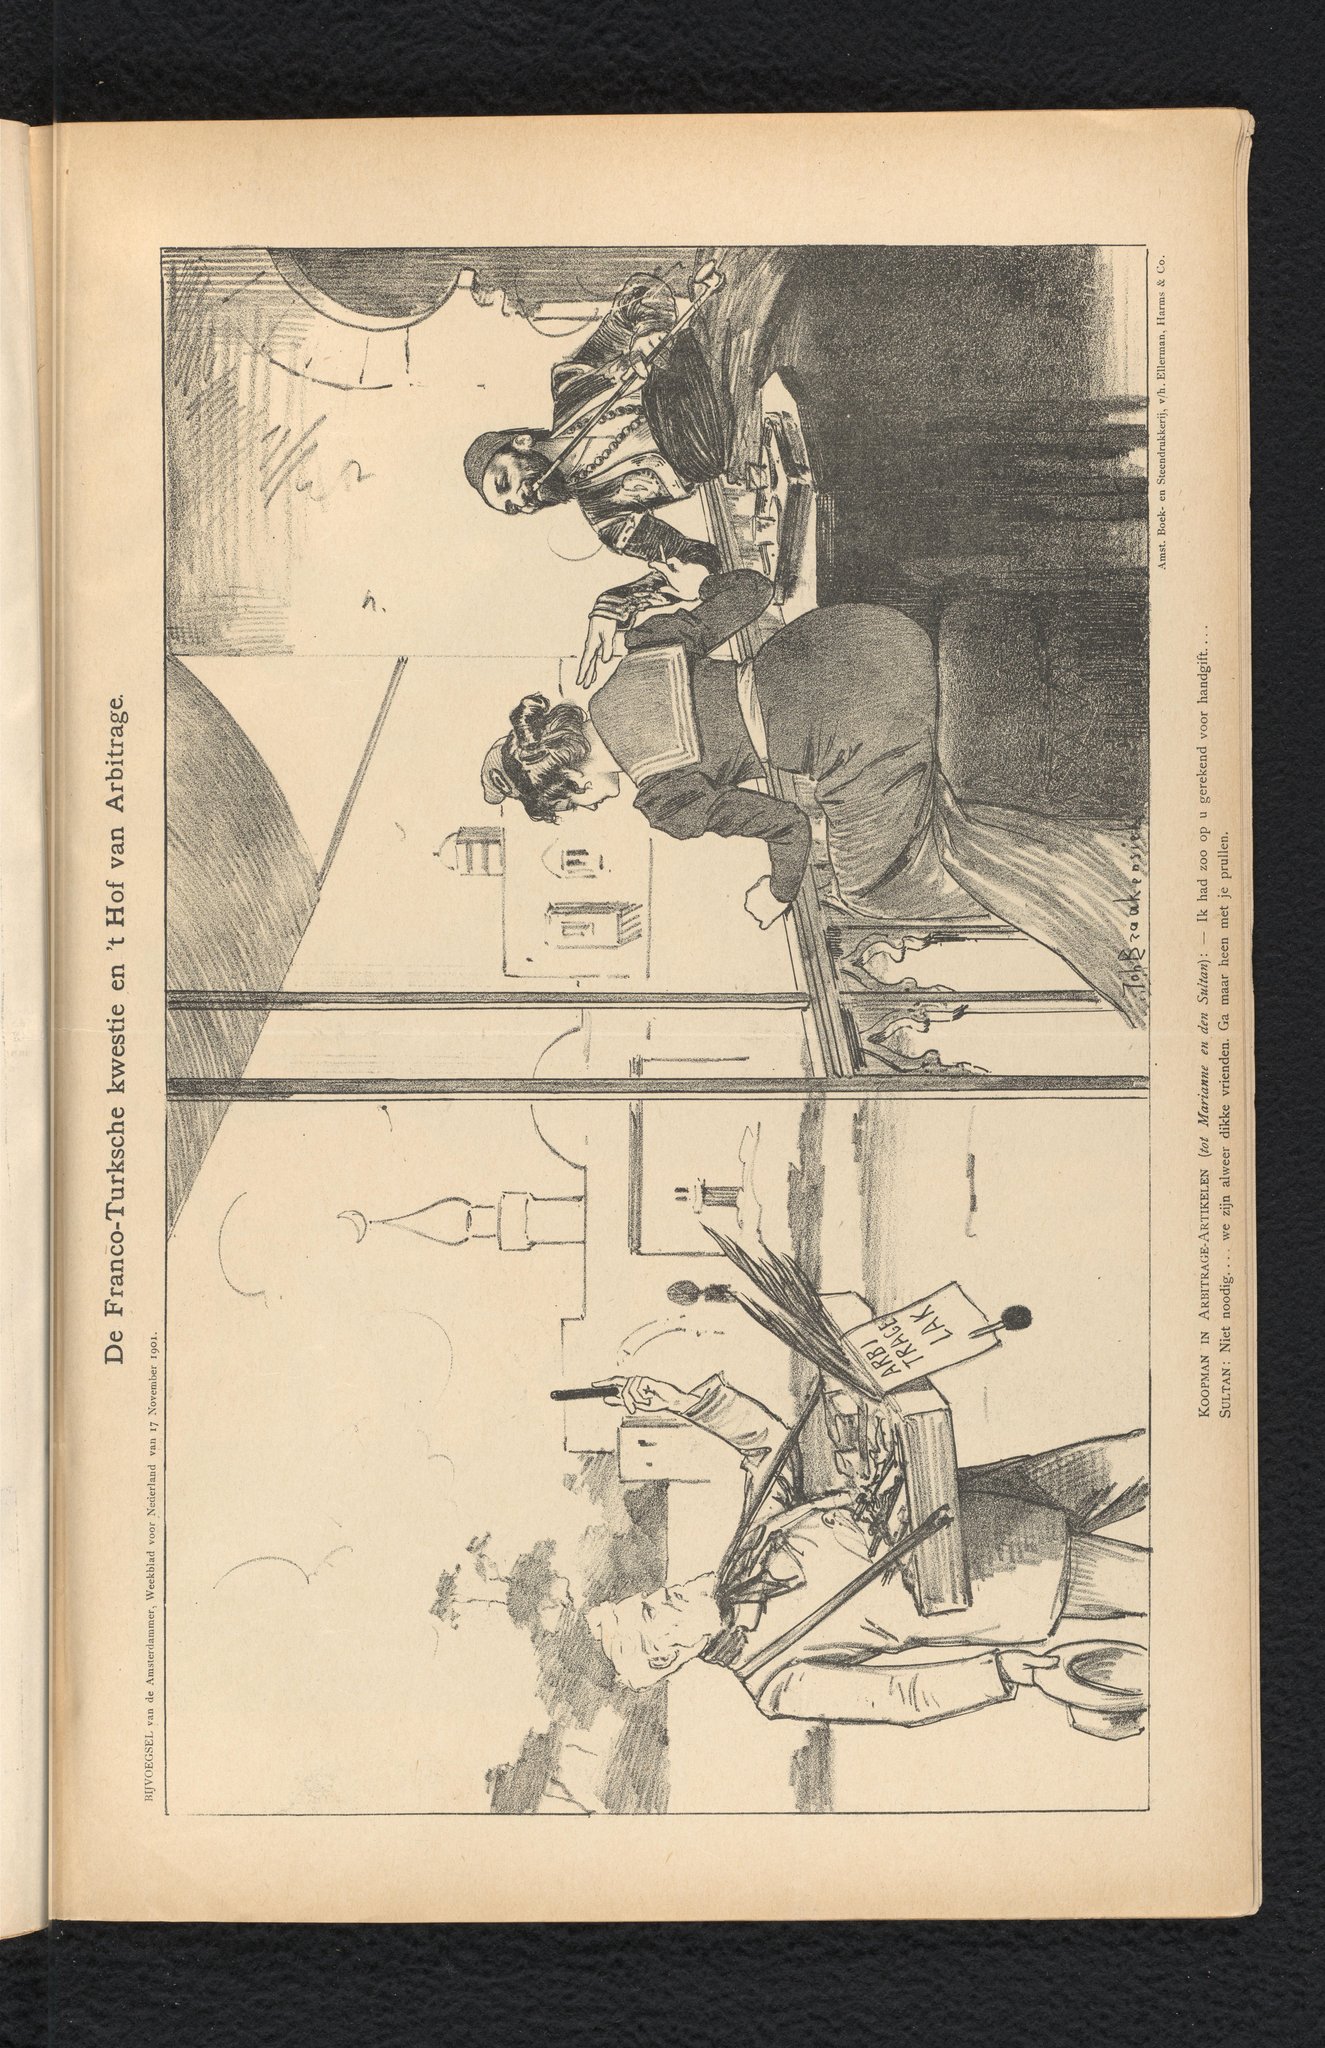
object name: cartoon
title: De Franco-Turksche kwestie en 't Hof van Arbitrage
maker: johan braakensiek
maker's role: draughtsman, print maker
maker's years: 1858-1940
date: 1901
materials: paper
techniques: lithograph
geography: netherlands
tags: personifications of countries, nations, states, districts, etc., wandering or travelling merchant, diplomacy, diplomat, political caricatures and satires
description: Baron van Lynden, Minister van Buitenlandse Zaken en secretaris-generaal van het Permanent Hof van Arbitrage probeert geld in te zamelen voor het hof door de verkoop van 'arbitrage-lak'. Frankrijk en de Ottomaanse sultan zijn echter niet geïnteresseerd.